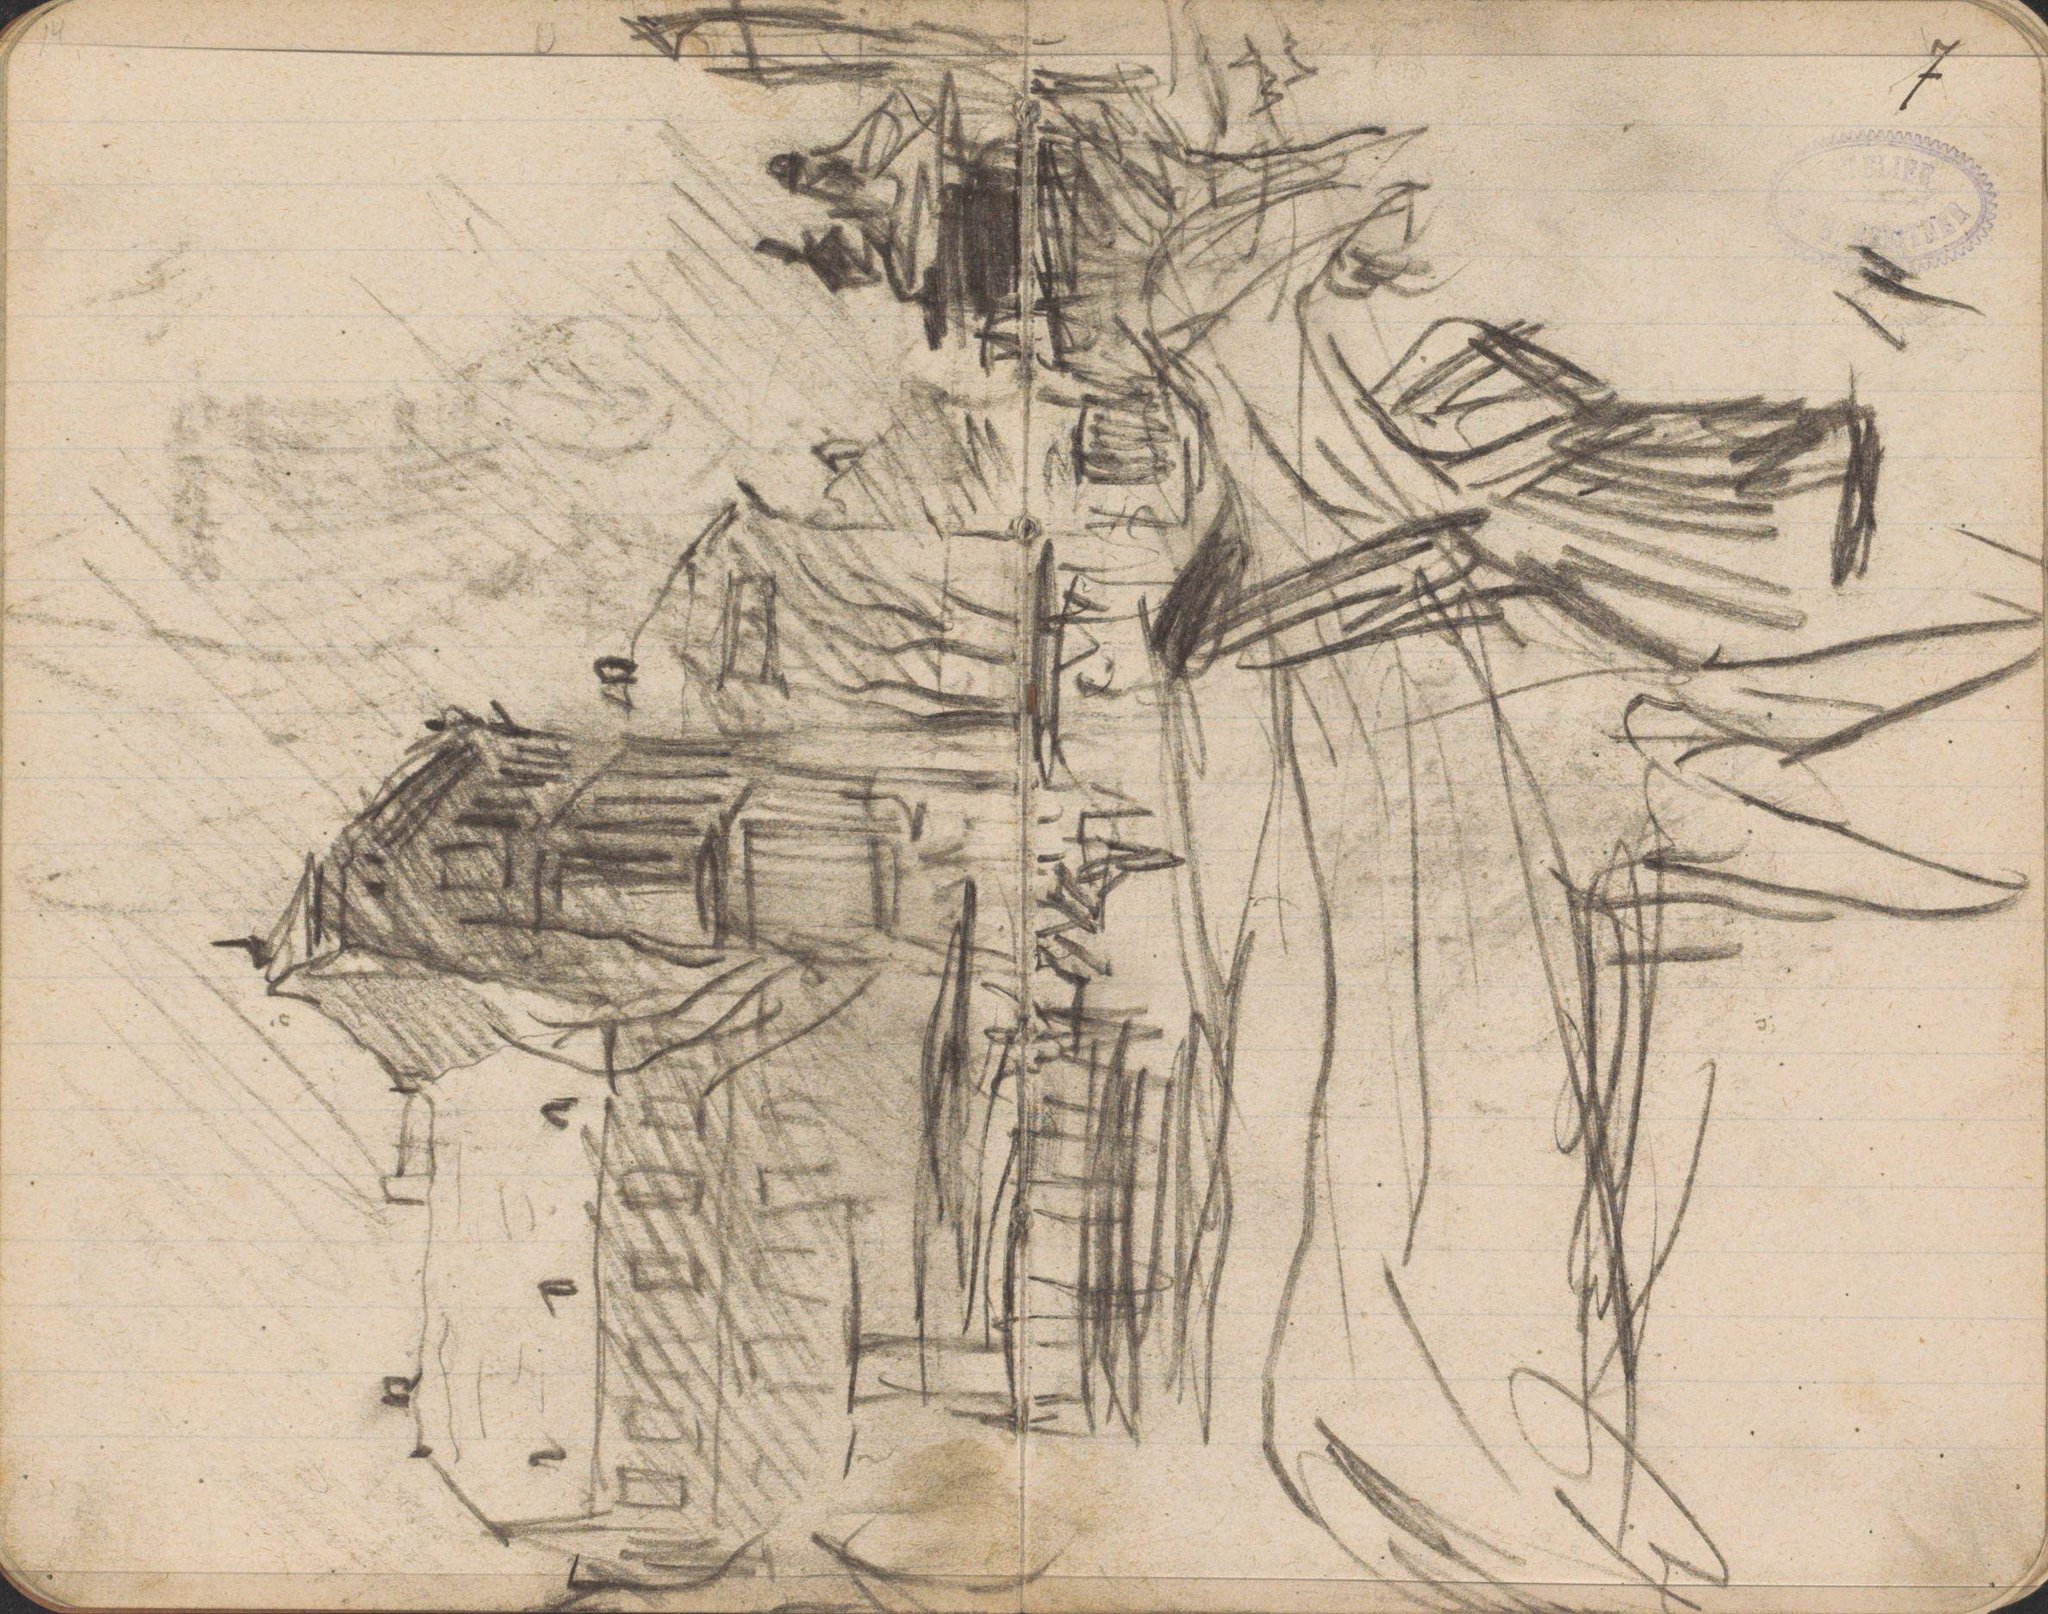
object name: sketchbook leaf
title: Rijtuigen, mogelijk op het Leidseplein te Amsterdam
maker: george hendrik breitner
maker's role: draughtsman, painter, print maker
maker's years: 1857-1923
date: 1882-1885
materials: chalk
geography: amsterdam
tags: horse, civic architecture; edifices; dwellings, square, place, circus, etc. (+ city(-scape) with figures, staffage)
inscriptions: workshop stamp: Lugt 291d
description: Pagina 14 en pagina 15 uit een schetsboek met 34 bladen.